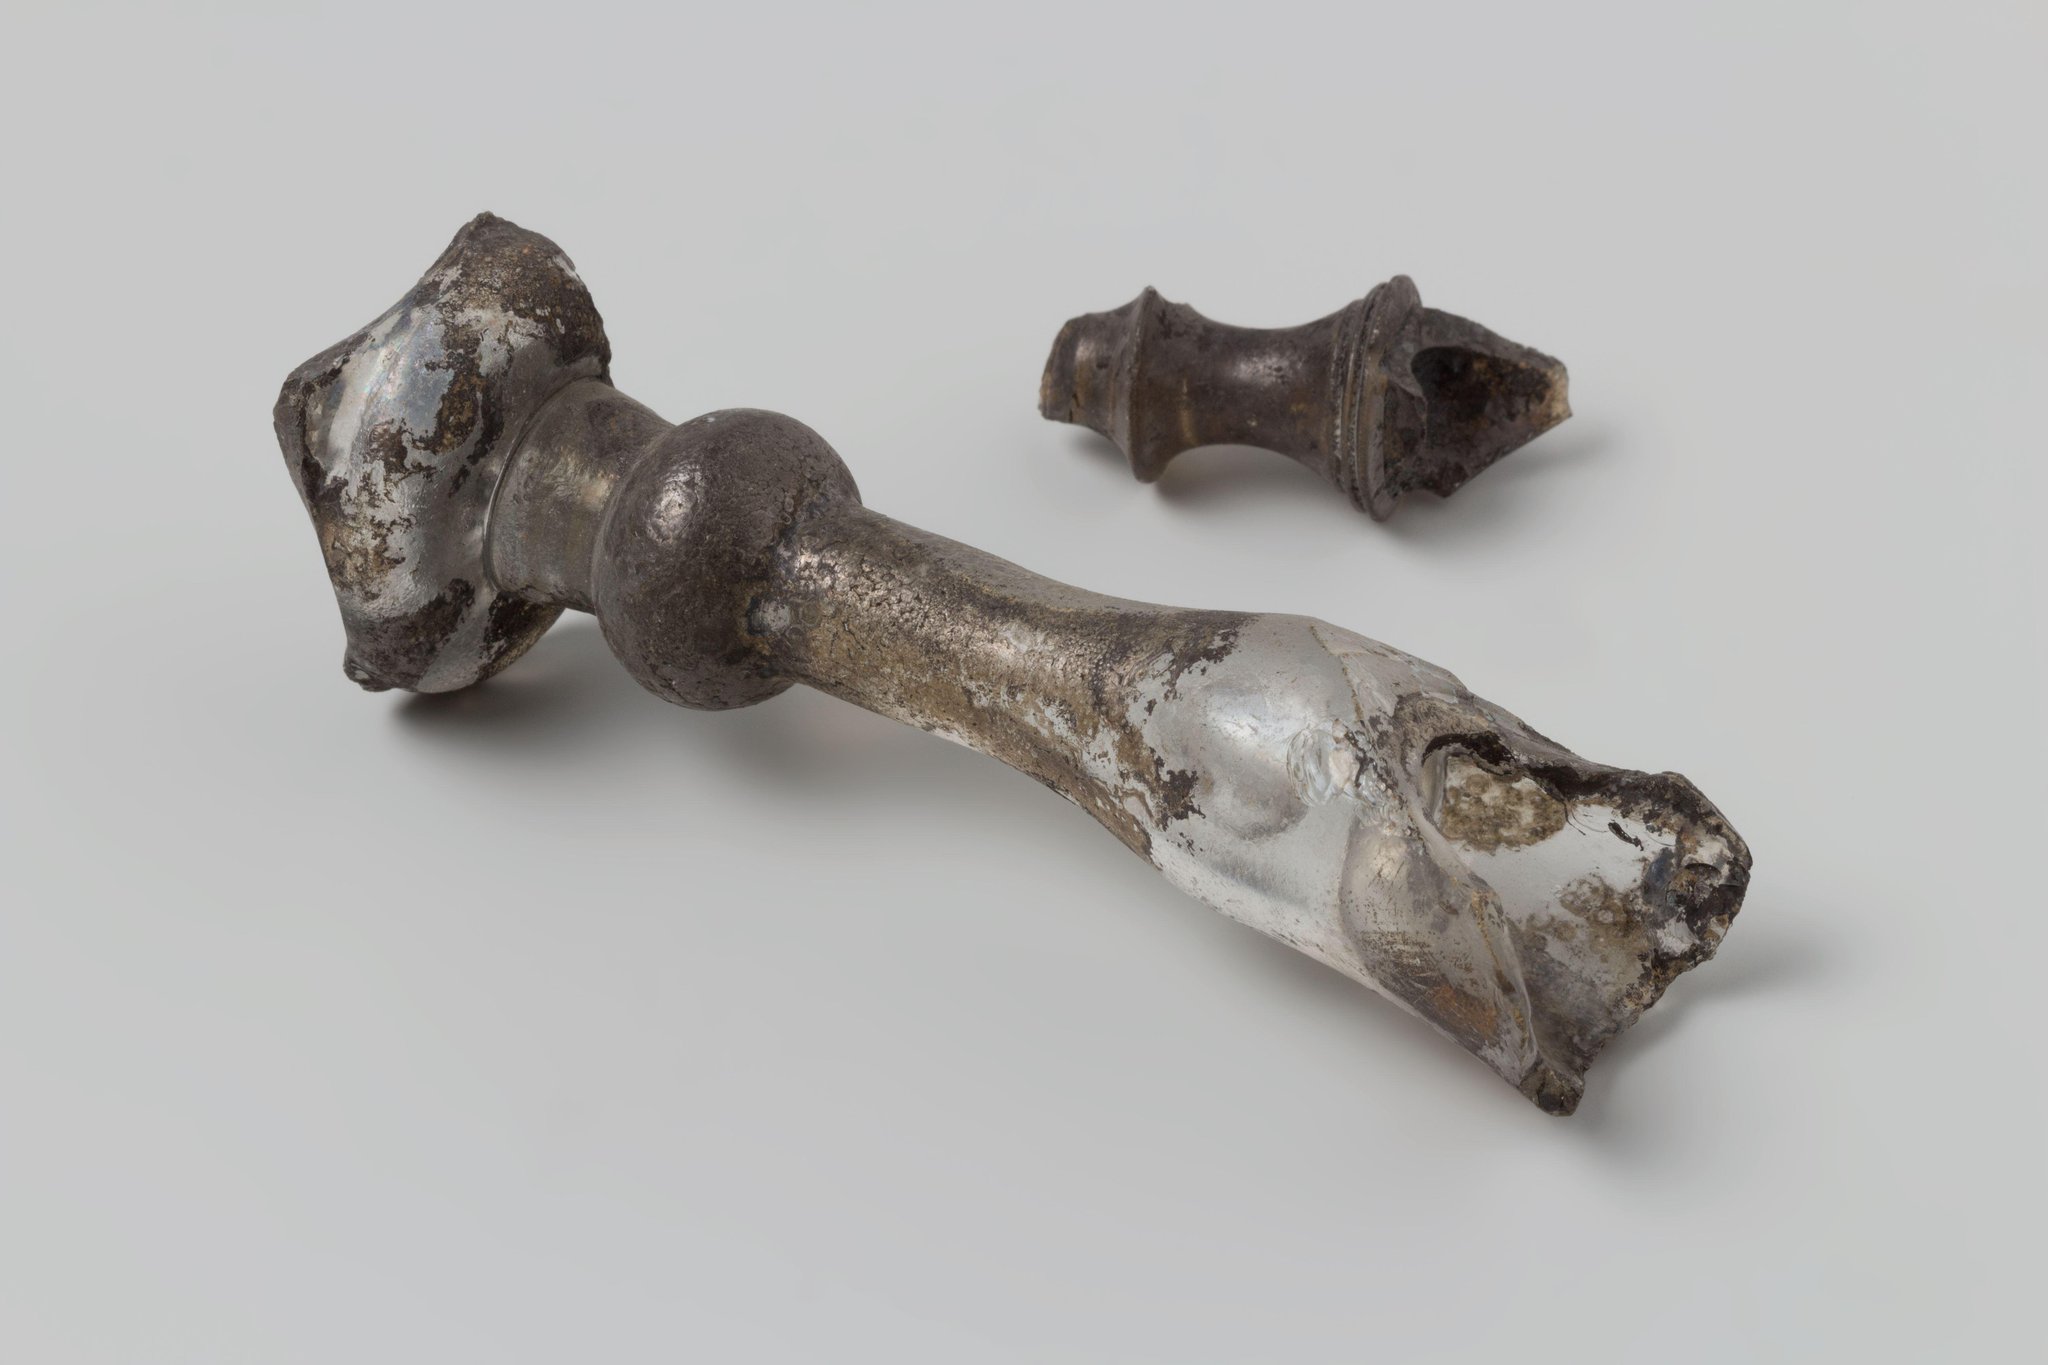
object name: fragment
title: Glasfragmenten uit V.O.C.-schip de 'Witte Leeuw'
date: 1613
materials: glass